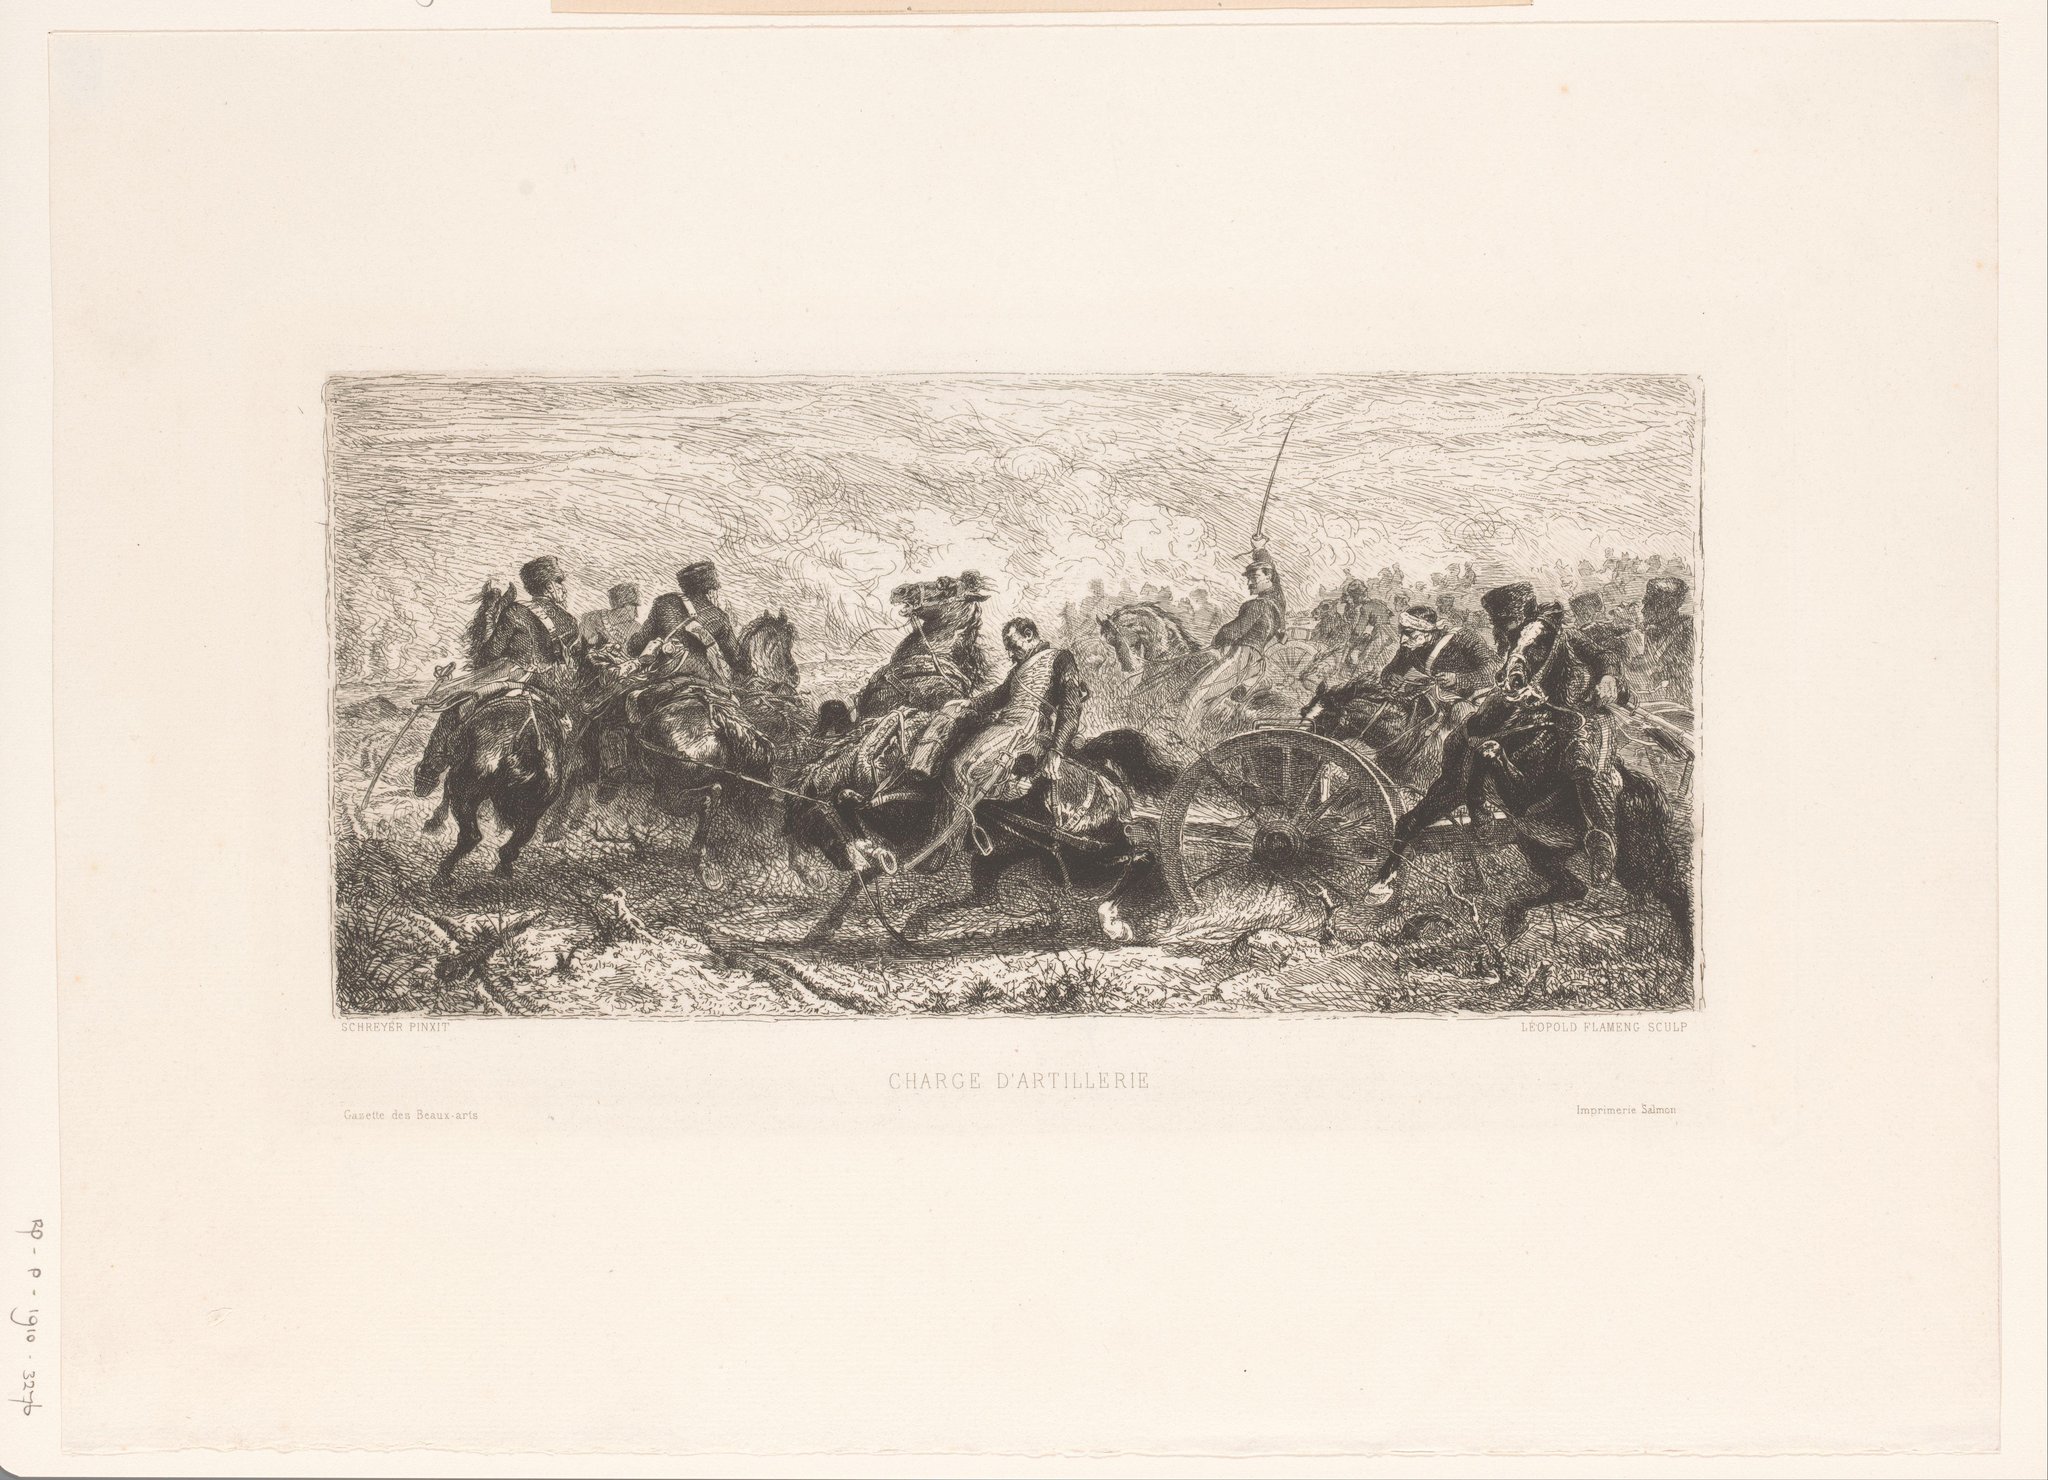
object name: print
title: Charge d'artillerie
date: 1865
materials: paper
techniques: etching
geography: paris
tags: the soldier; the soldier's life (+ artillery)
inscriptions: collector's mark: Lugt 2228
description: Prent uit: Gazette des beaux-arts (juli 1865), p. 6-7.